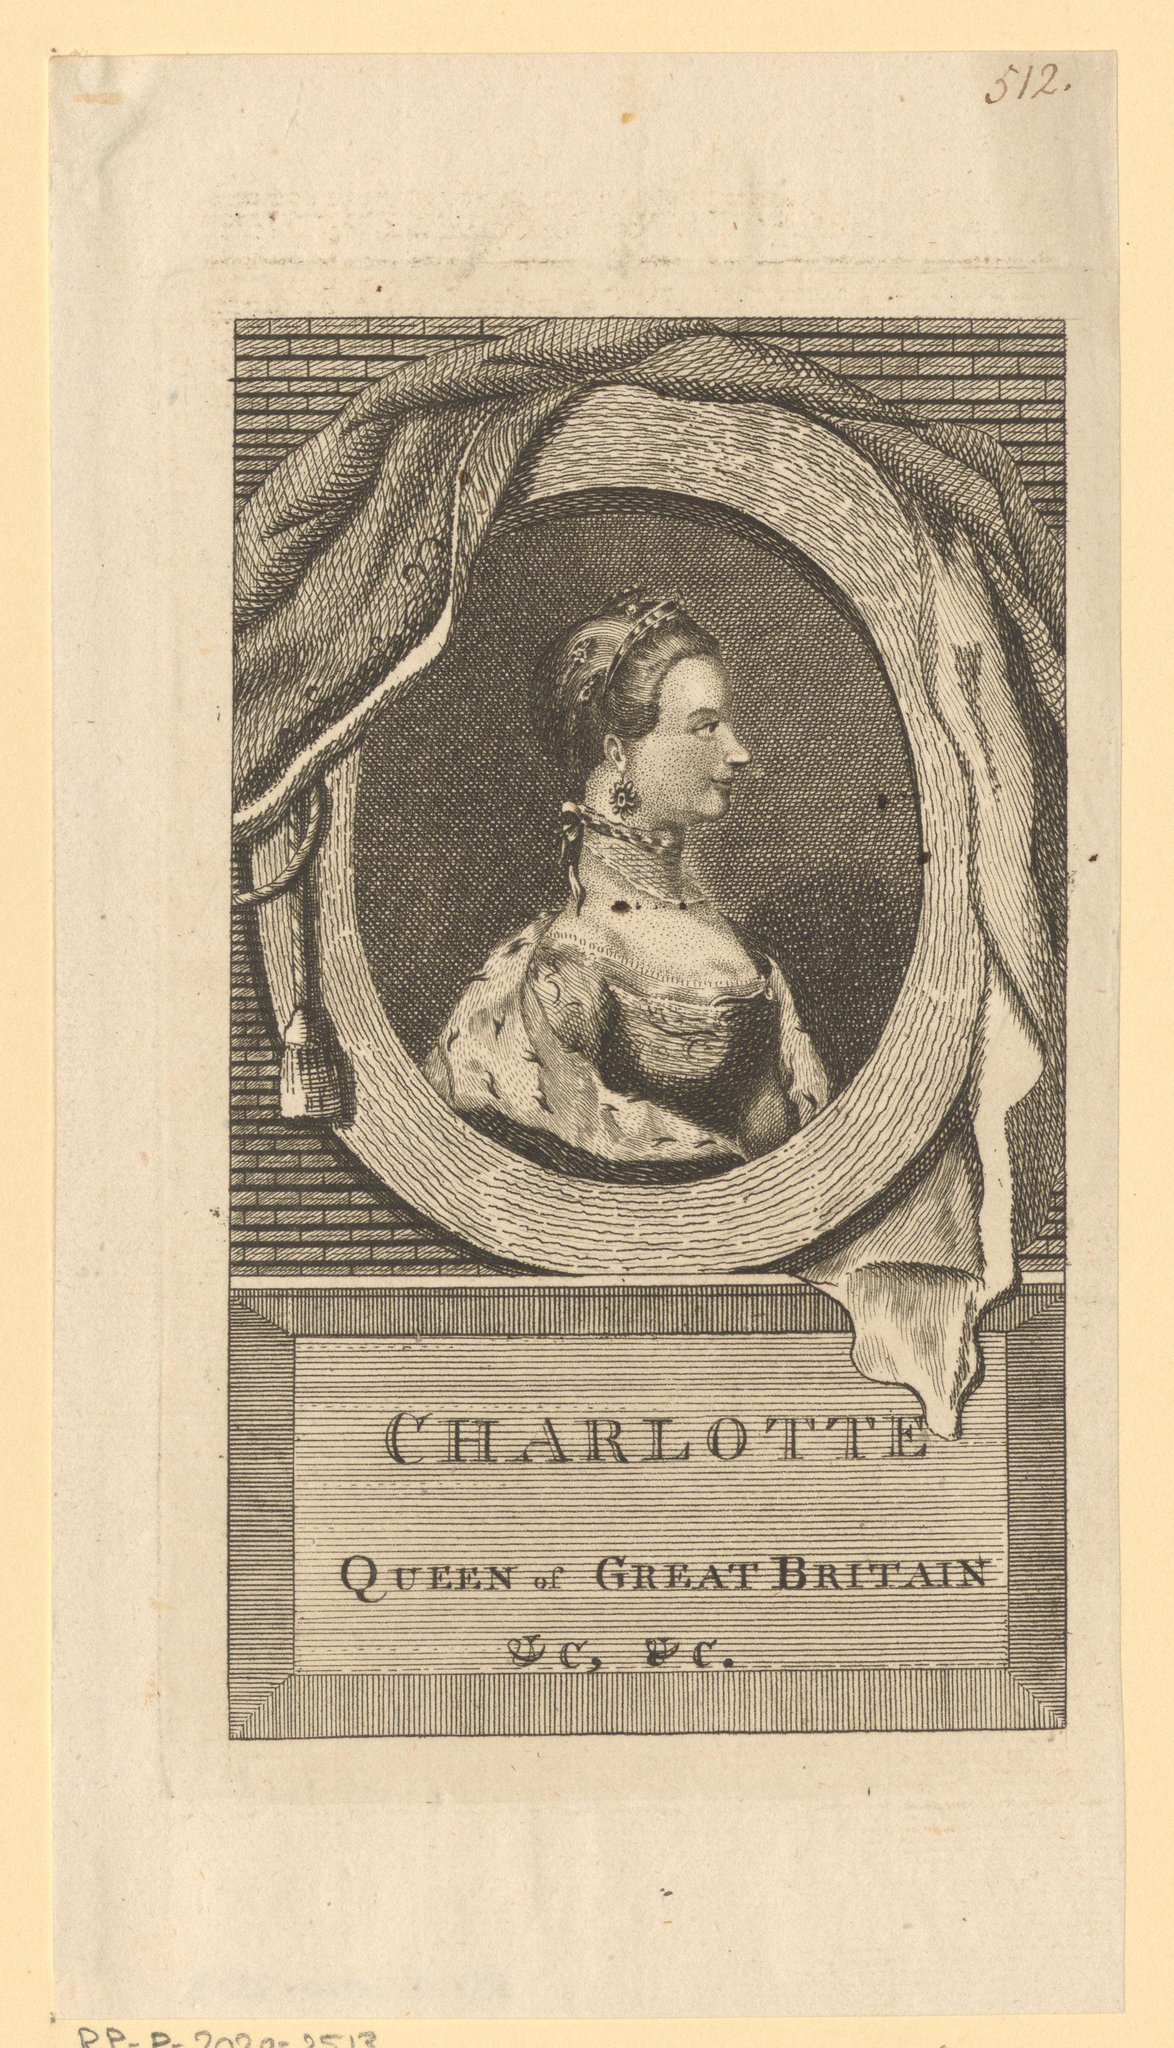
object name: print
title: Portret van Charlotte van Mecklenburg-Strelitz, koningin van Engeland en Ierland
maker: Anonymous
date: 1761-1818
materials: paper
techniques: engraving, etching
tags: united kingdom, charlotte van mecklenburg-strelitz (koningin van engeland en ierland), historical persons - bb - woman, queen